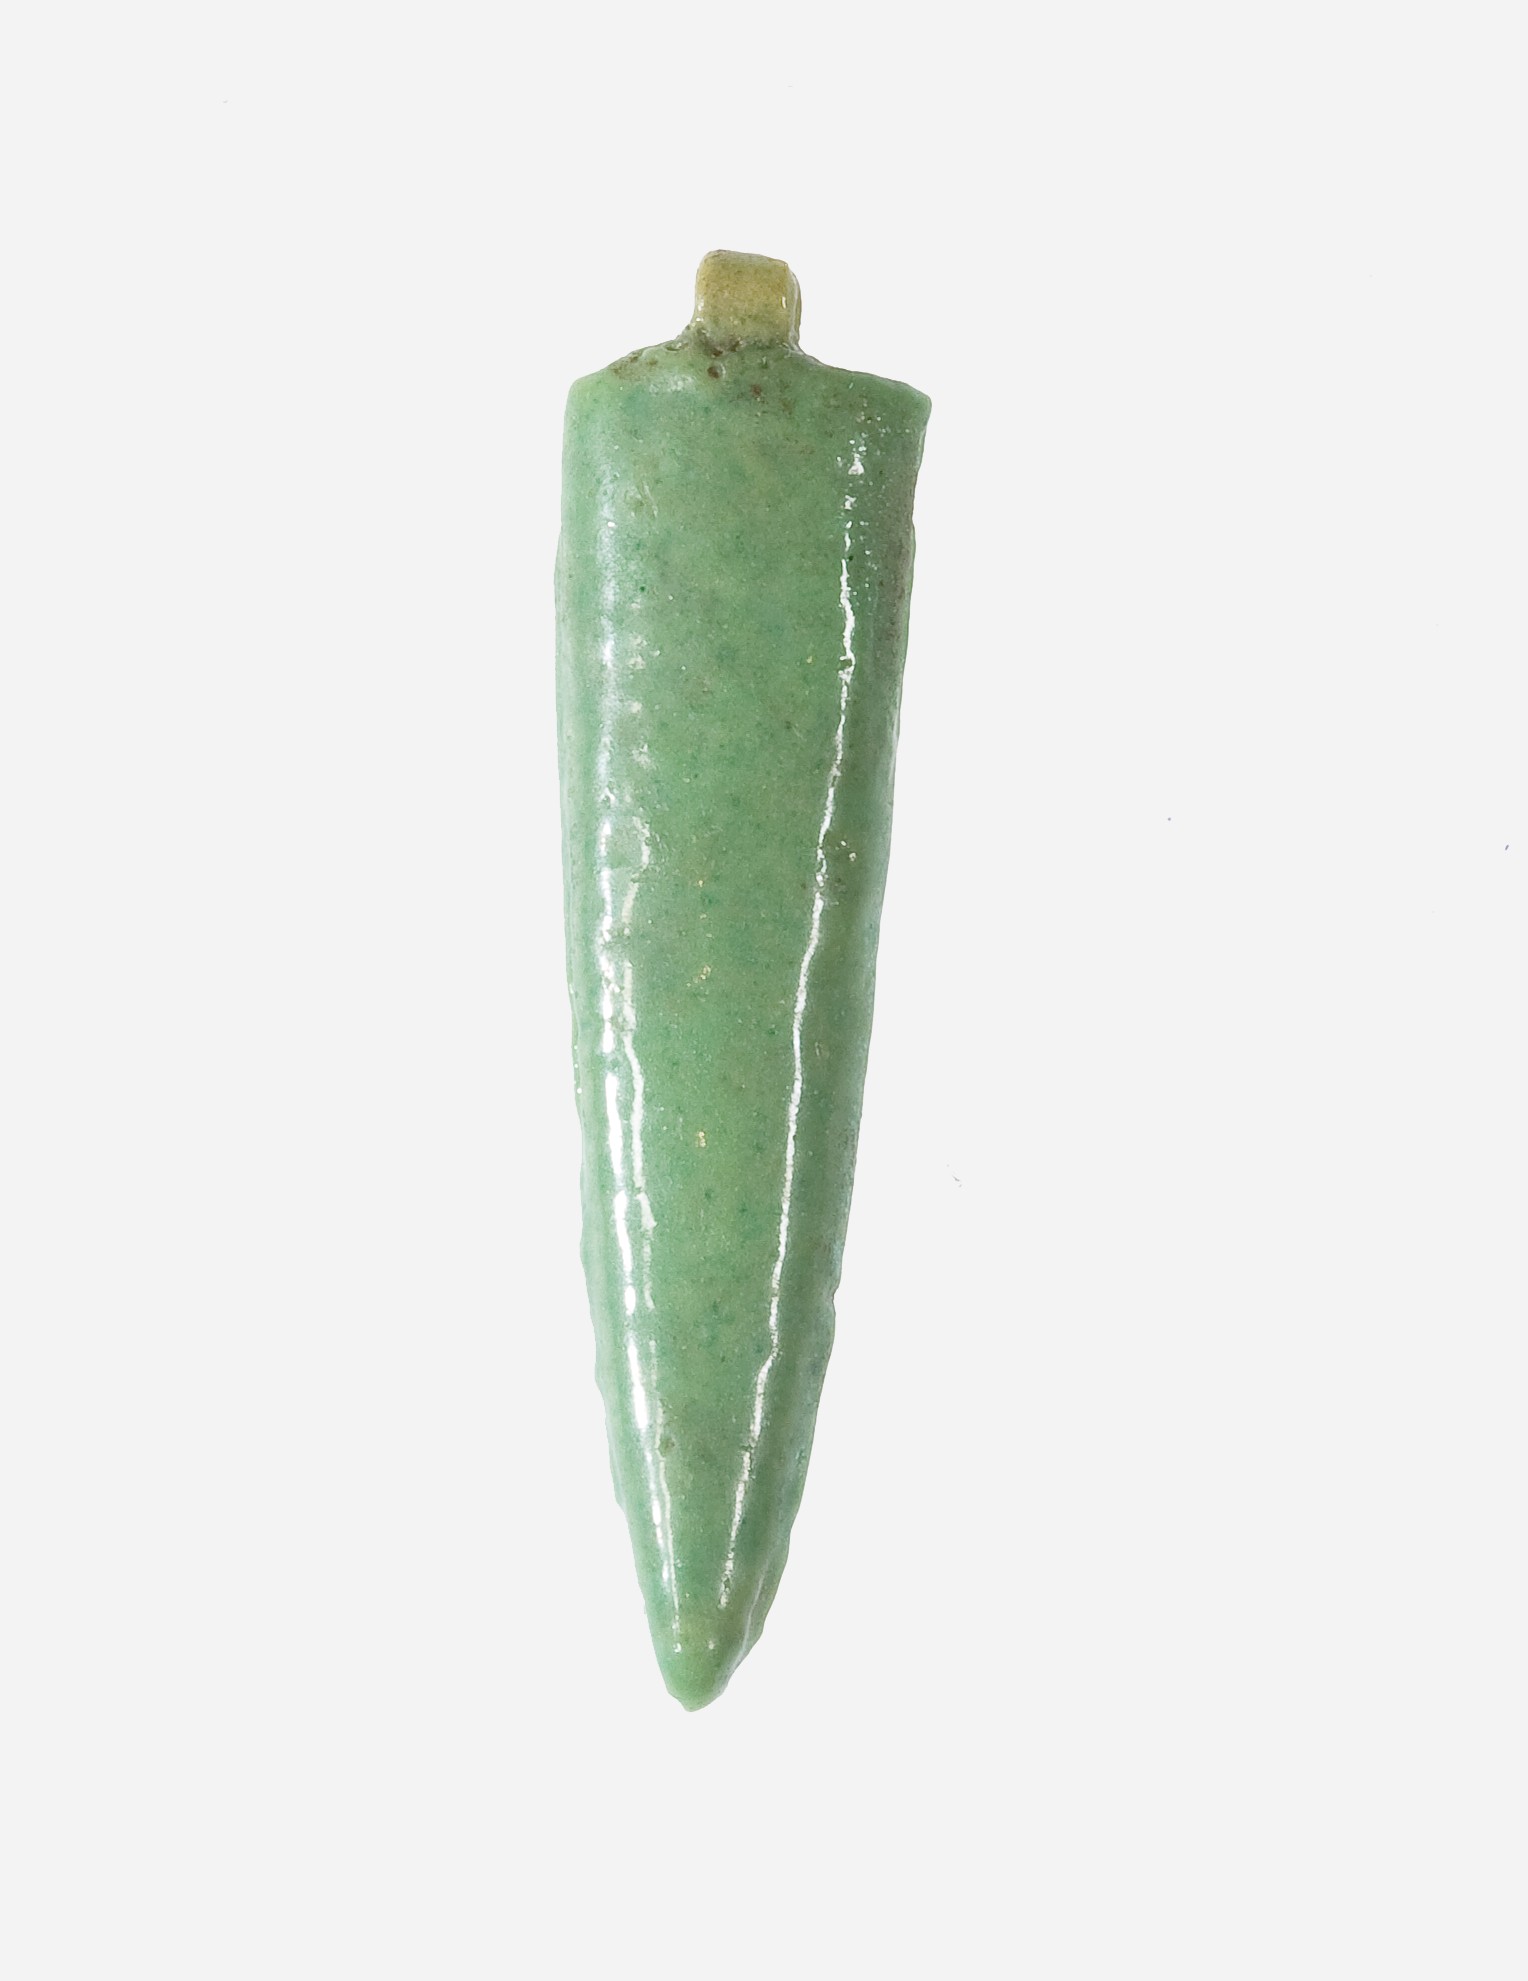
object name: bead, lotus sepal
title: Bead in the Form of a Lotus Sepal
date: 1390-1352 BCE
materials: faience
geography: egypt